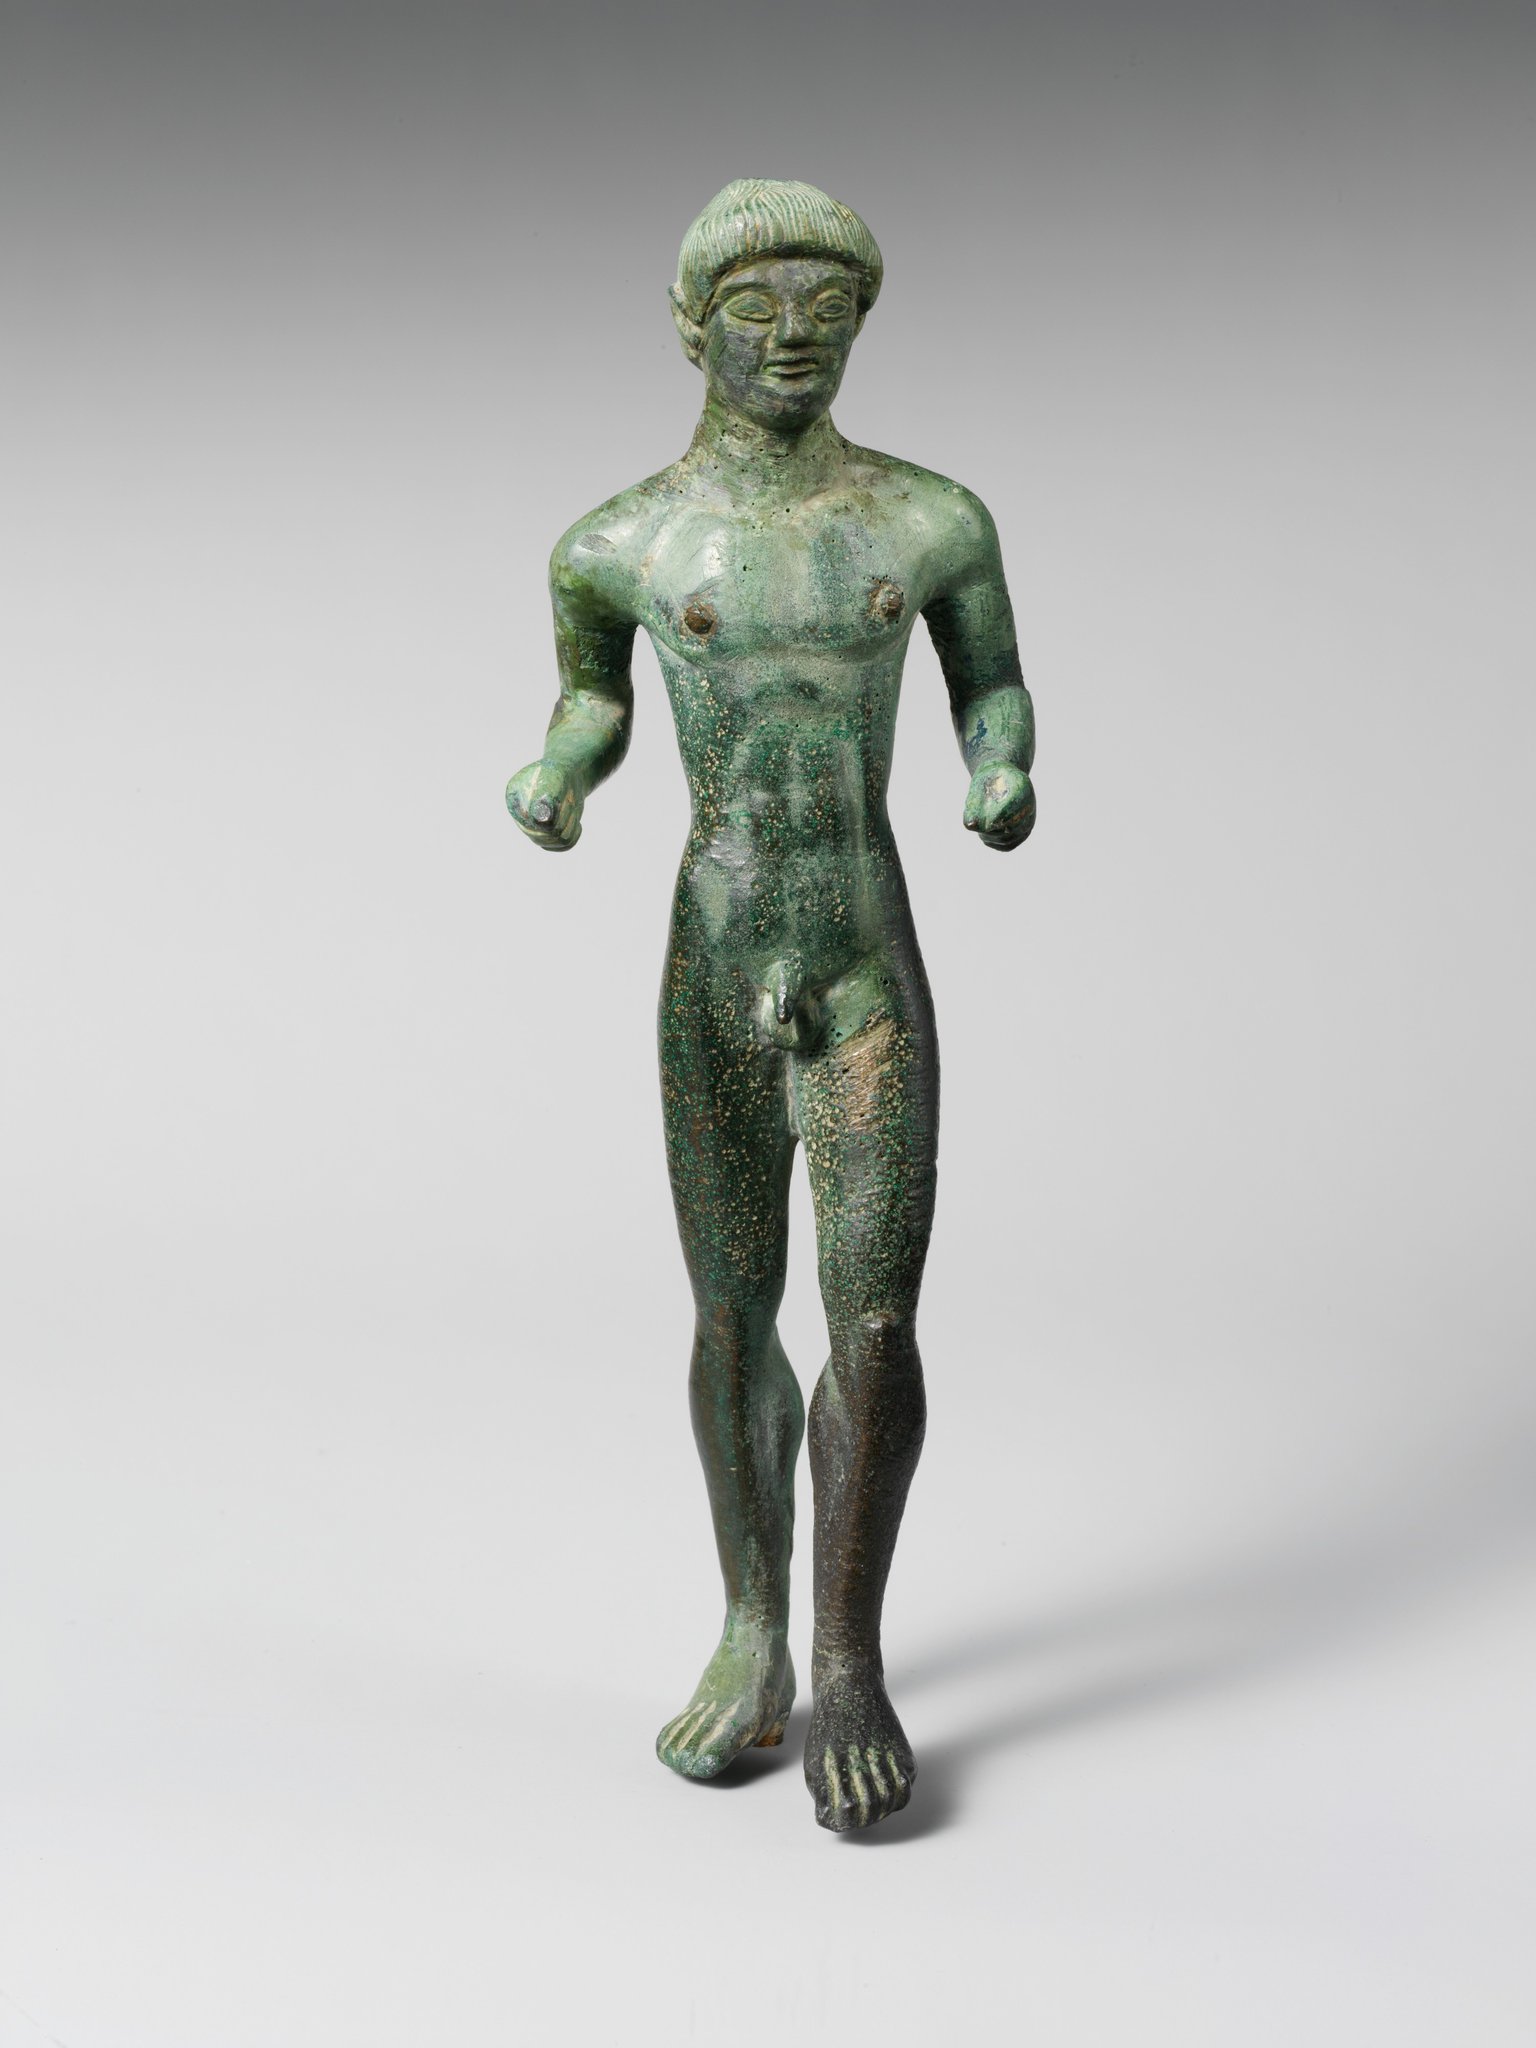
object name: statuette of an athlete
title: Bronze statuette of a youth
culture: etruscan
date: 534-501 BCE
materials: bronze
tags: male nudes